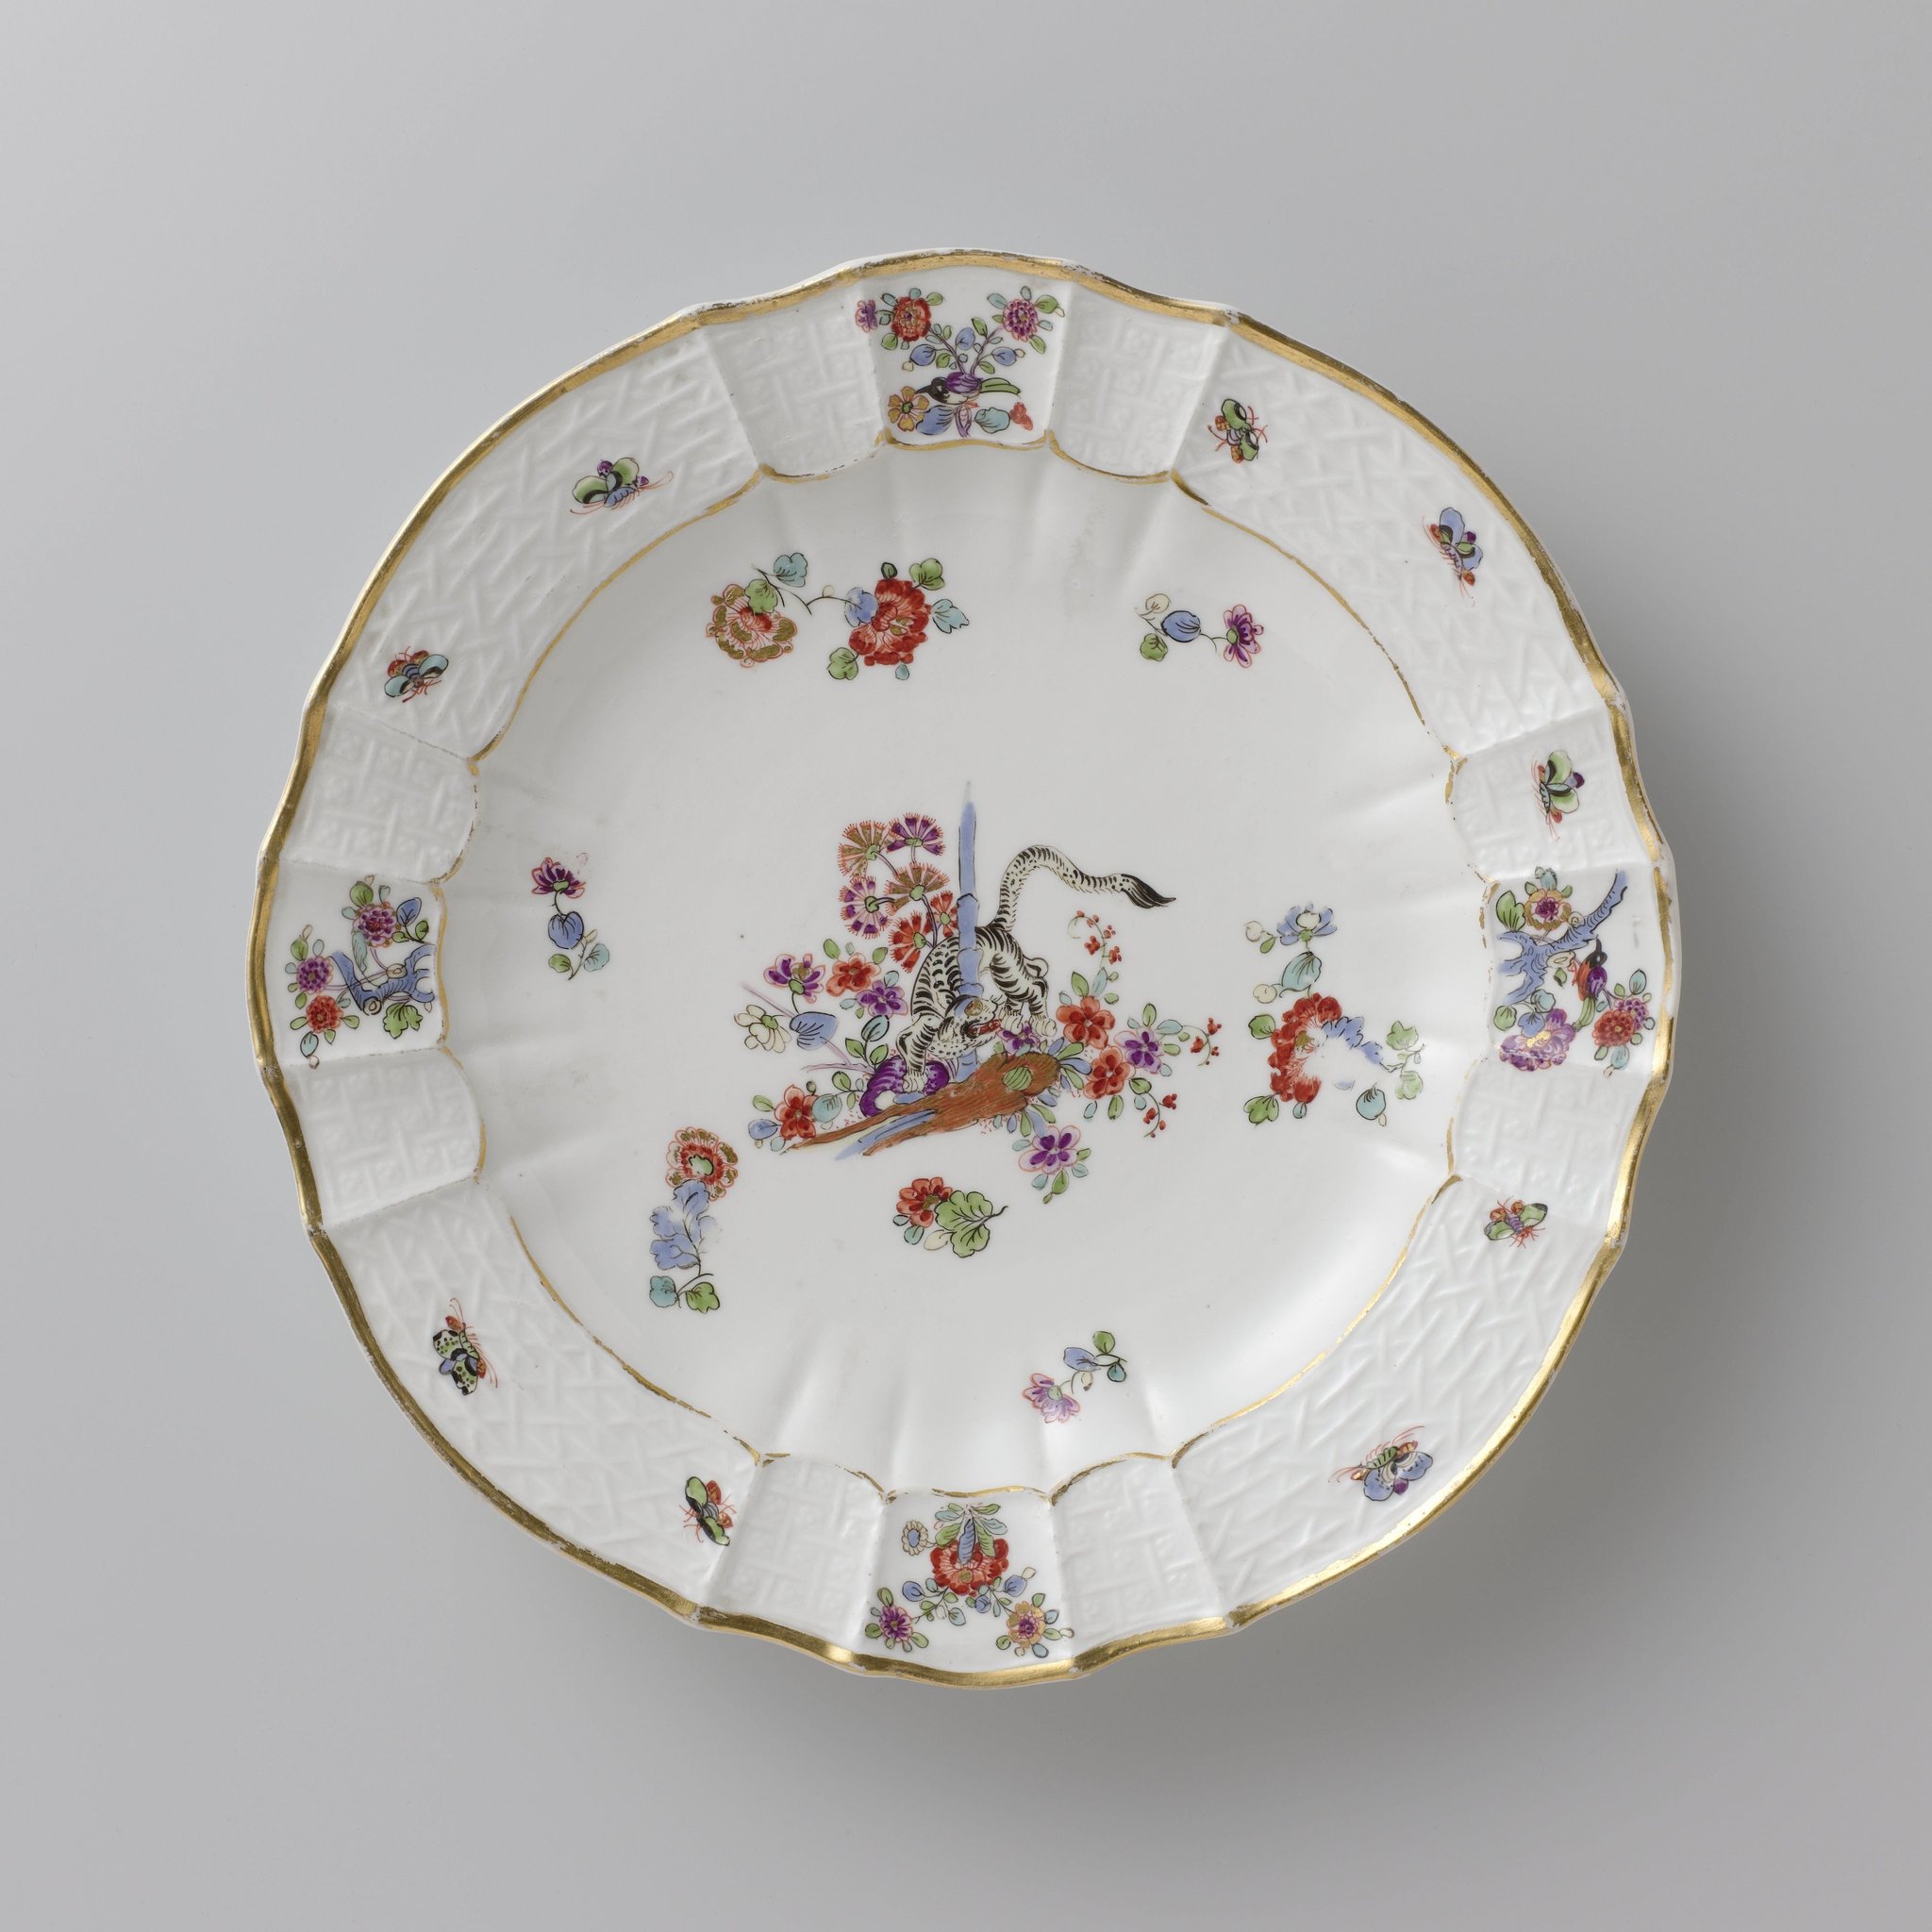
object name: eating drinking utensil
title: Rond bord, veelkleurig beschilderd met een Kakiemon-decor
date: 1740-1745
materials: porcelain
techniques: painted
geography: meissen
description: Rond bord van beschilderd porselein. Het bord is geribd en heeft een geschulpte rand. Het bord is beschilderd met een tijger die om een blauwe bamboestengel tussen bloemen is gedraaid, gestrooide Indianische Blumen, vlinders en takken waarop vogels. De rand is versierd met het 'Altbrandenstein'-patroon. Het bord is gemerkt.